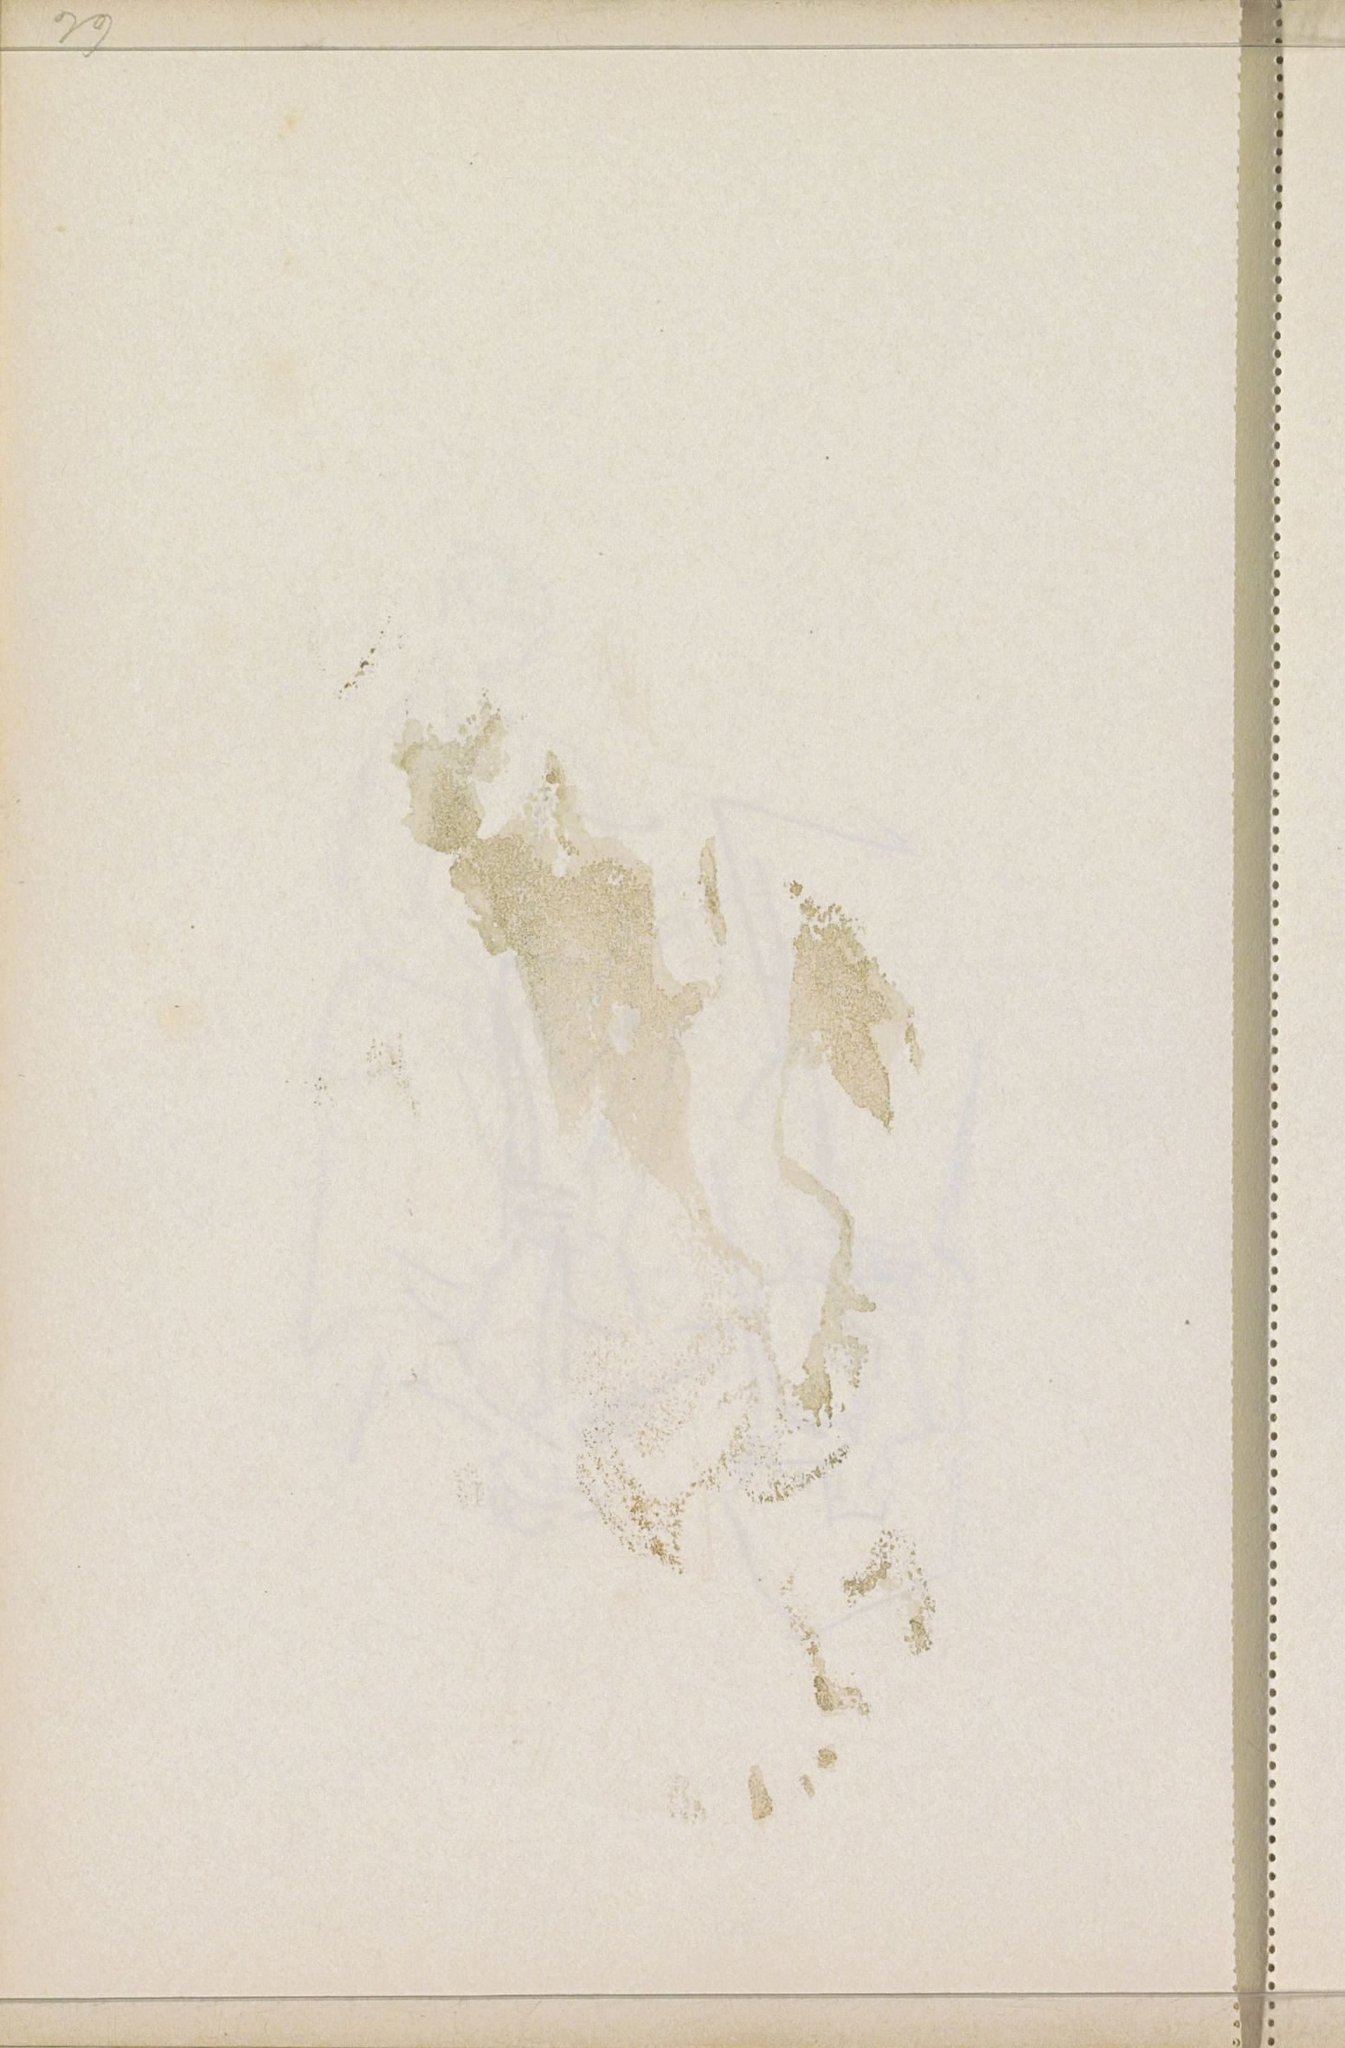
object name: sketchbook leaf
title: Abklatsch van de penseeltekening op blad 22 recto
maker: isaac israels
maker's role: draughtsman, painter, print maker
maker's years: 1865-1934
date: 1875-1934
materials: paper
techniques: printmaking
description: Blad 21 verso uit schetsboek LII met 43 bladen.